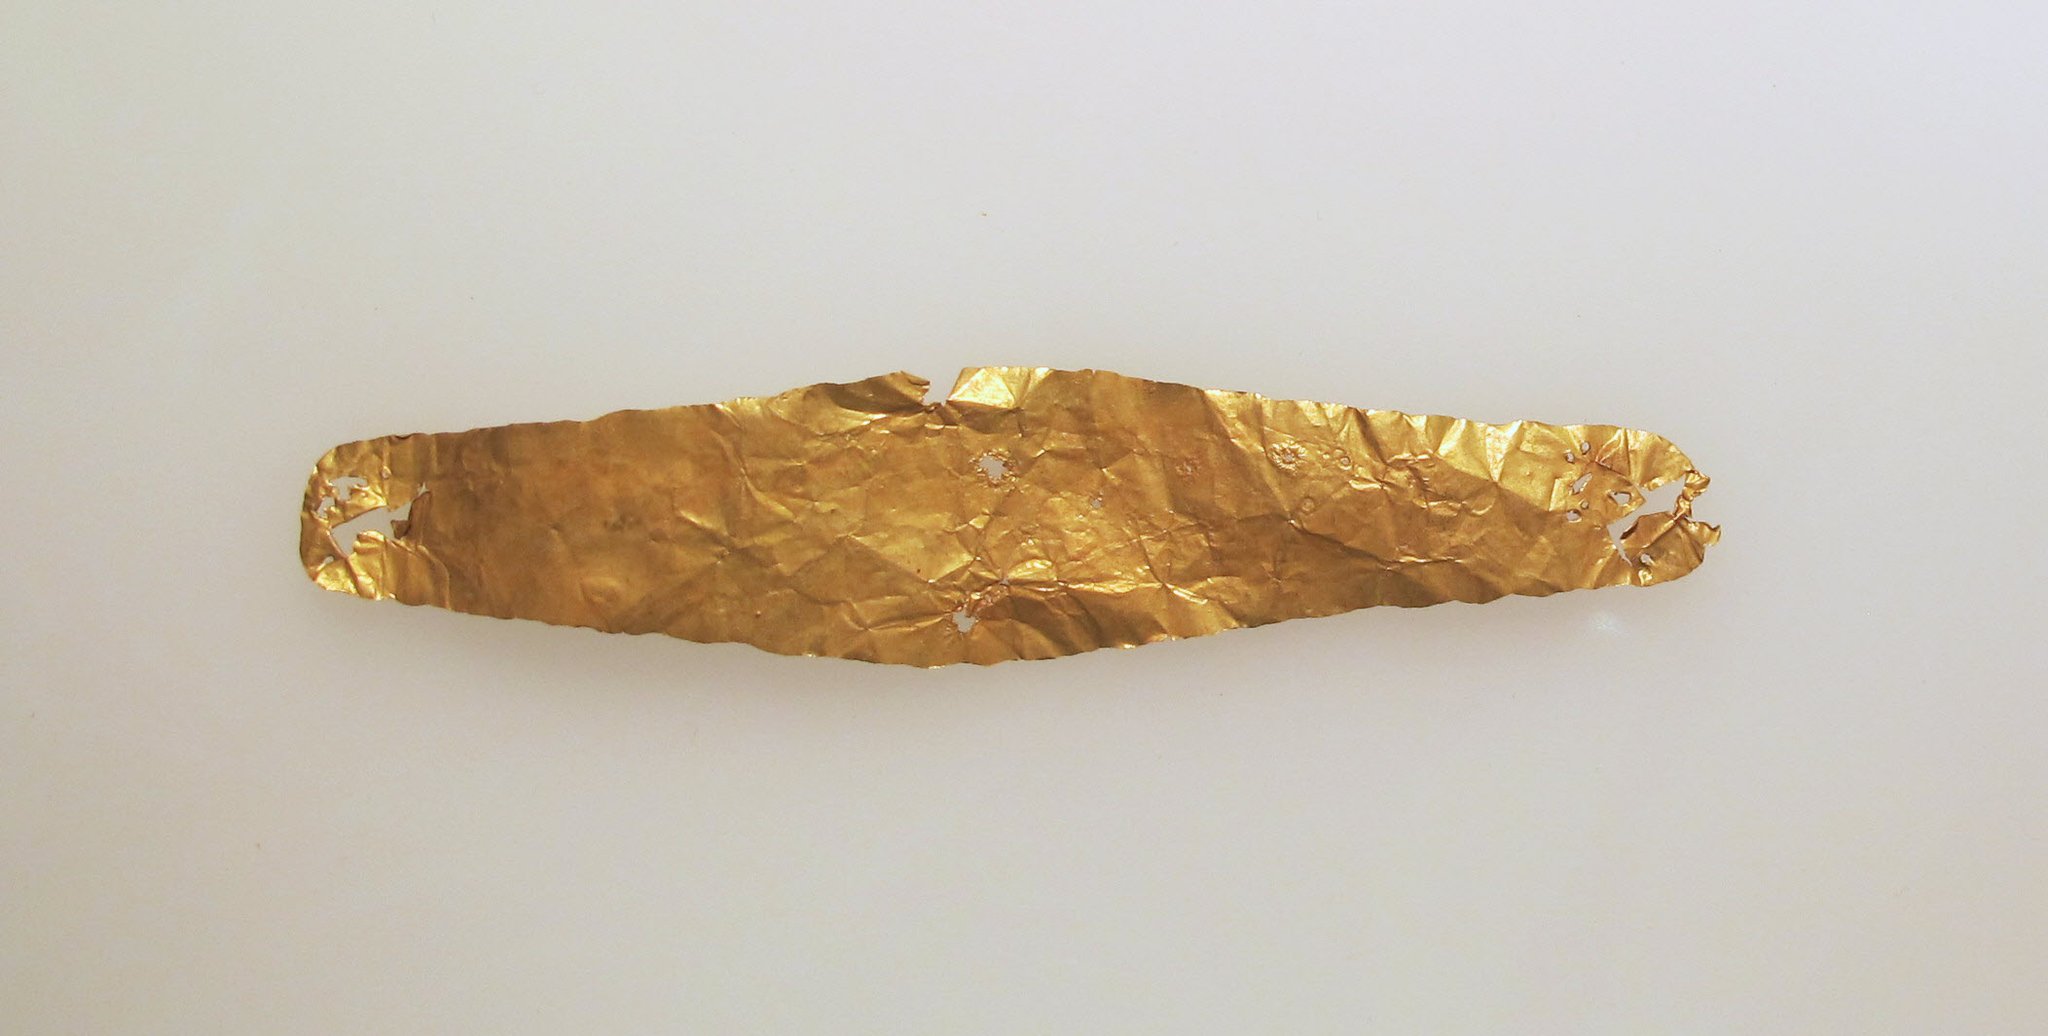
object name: frontlet of gold leaf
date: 7000 BCE-330 CE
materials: gold